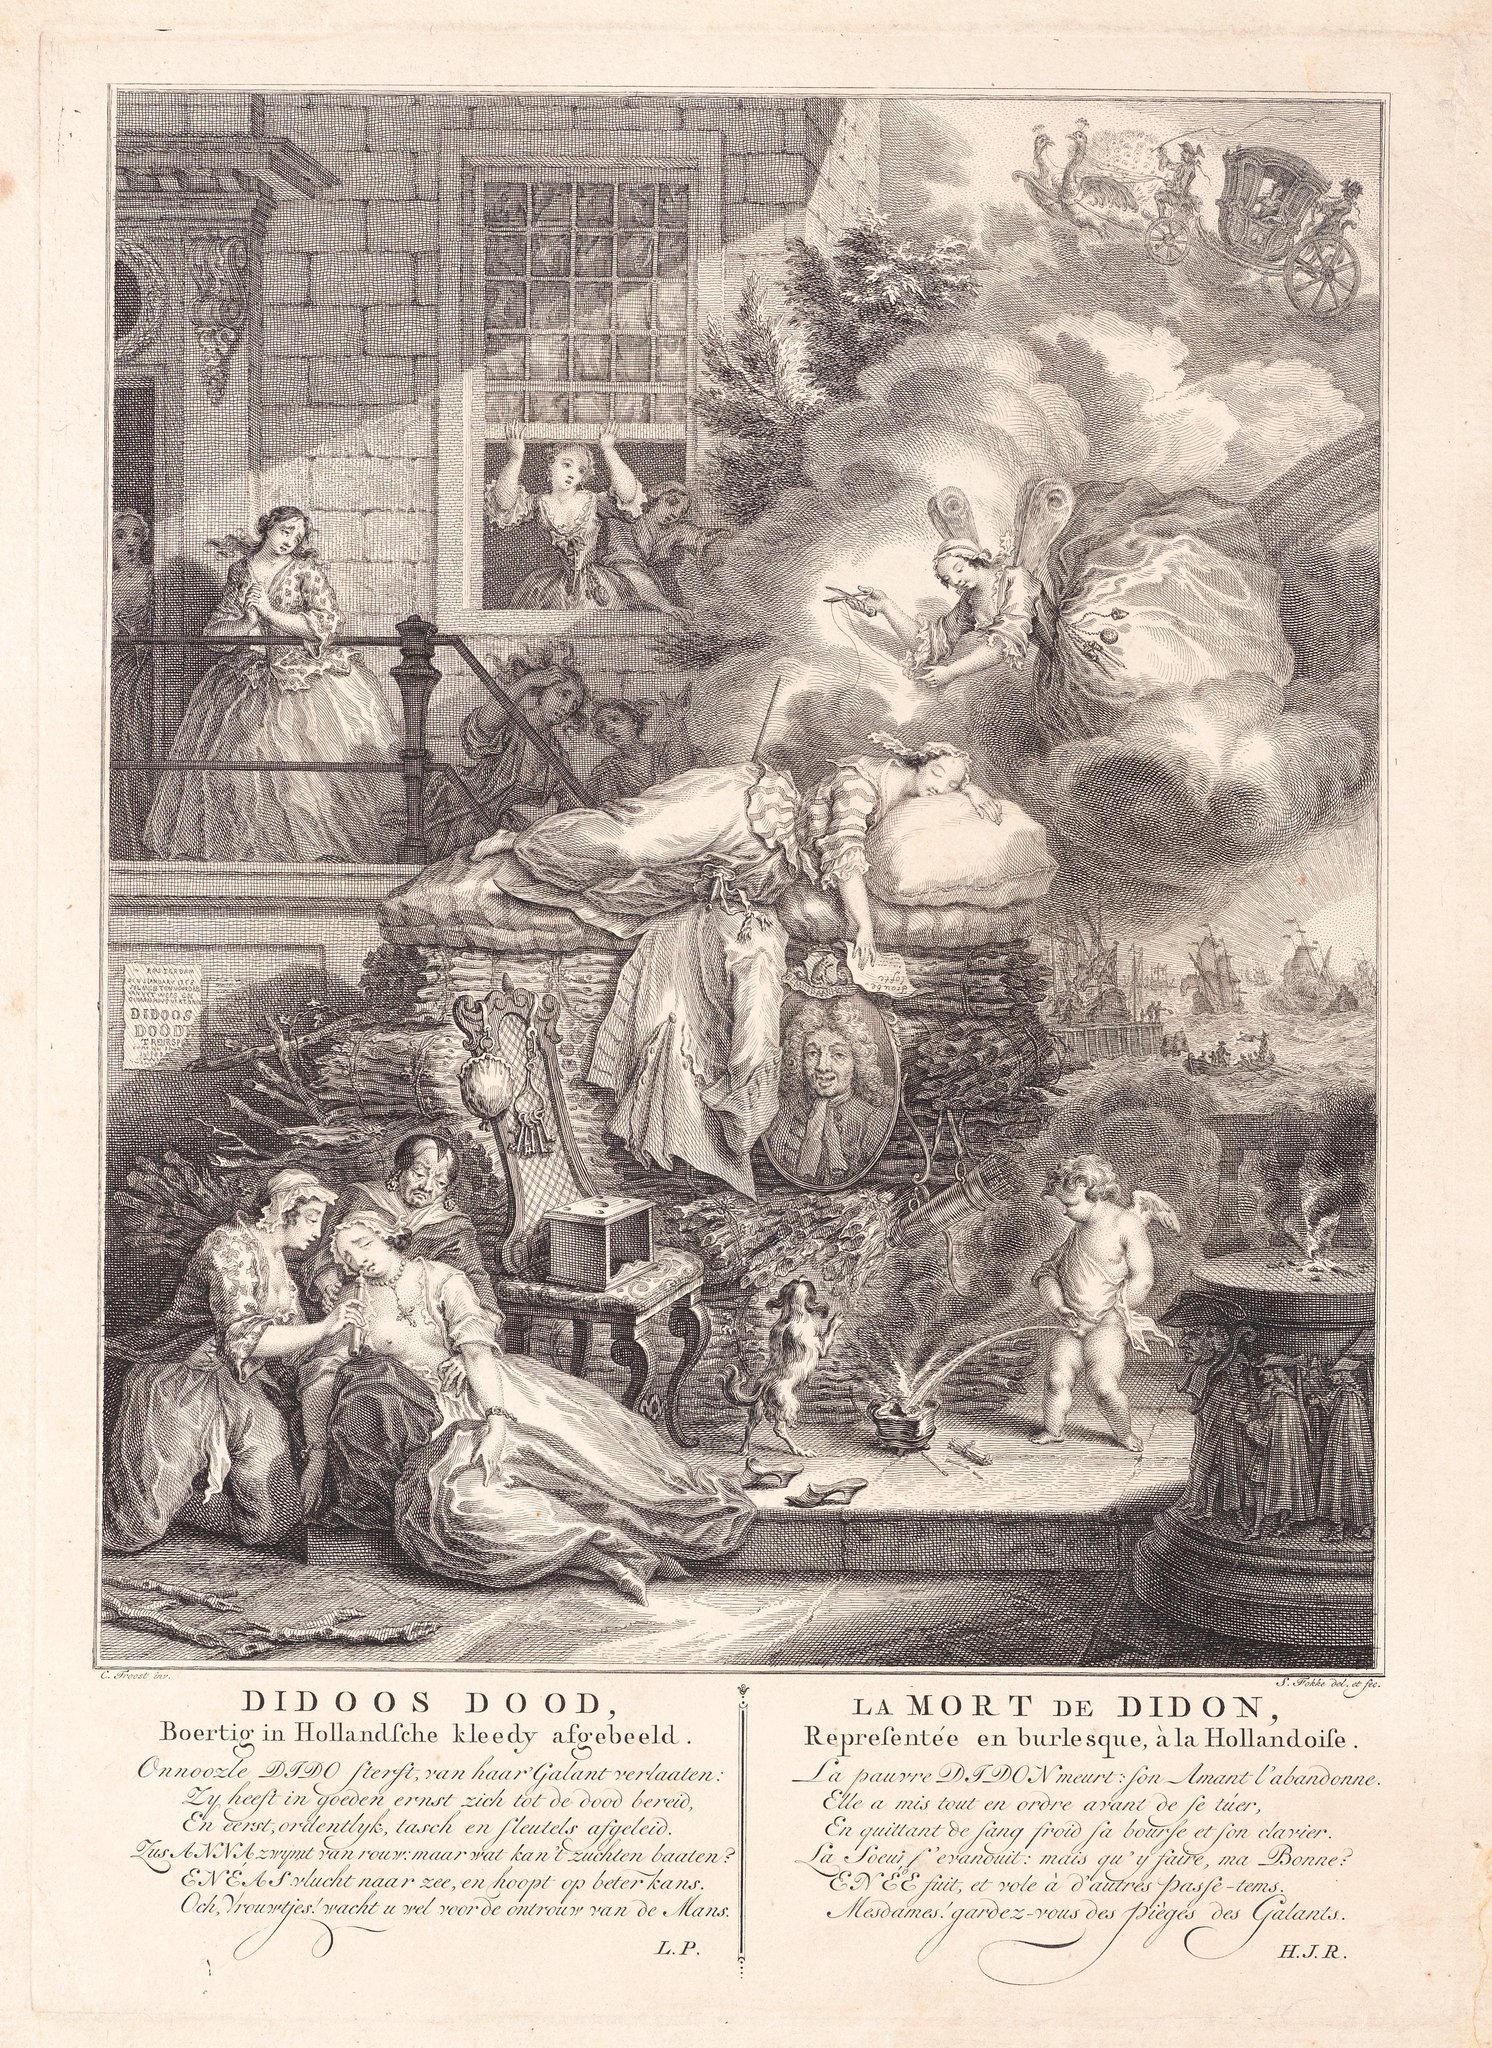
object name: print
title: Didoos Dood, Boertig in Hollandsche kleedy afgebeeld / La Mort de Didon, Representée en burlesque, à la Hollandoise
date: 1758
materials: paper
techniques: engraving, etching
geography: amsterdam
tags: extinguishing a fire, (story of) dido - death, tragedy, urination, fainting, swooning - bb - out of doors, smoking pot as symbol of 'vanitas'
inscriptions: collector's mark: Lugt 2488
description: Het doorstoken lichaam van Dido liggend op een houtstapel voor een Amsterdamse grachtenhuis. Iris, een gevleugelde vrouwenfiguur, knipt een lok van haar haar af waarmee haar ziel bevrijd wordt. Op de brandstapel een portret van 'Wigmana'. Links pist een Cupido het vuur in een testje uit. Op de voorgrond links wordt een flauwgevallen vrouw bijgebracht. Mogelijk houdt de voorstelling verband met het toneelstuk 'Didoos Doot' van Andries Pels (1668). Onderaan in de marge twee zesregelige verzen in het Nederlands en Frans.